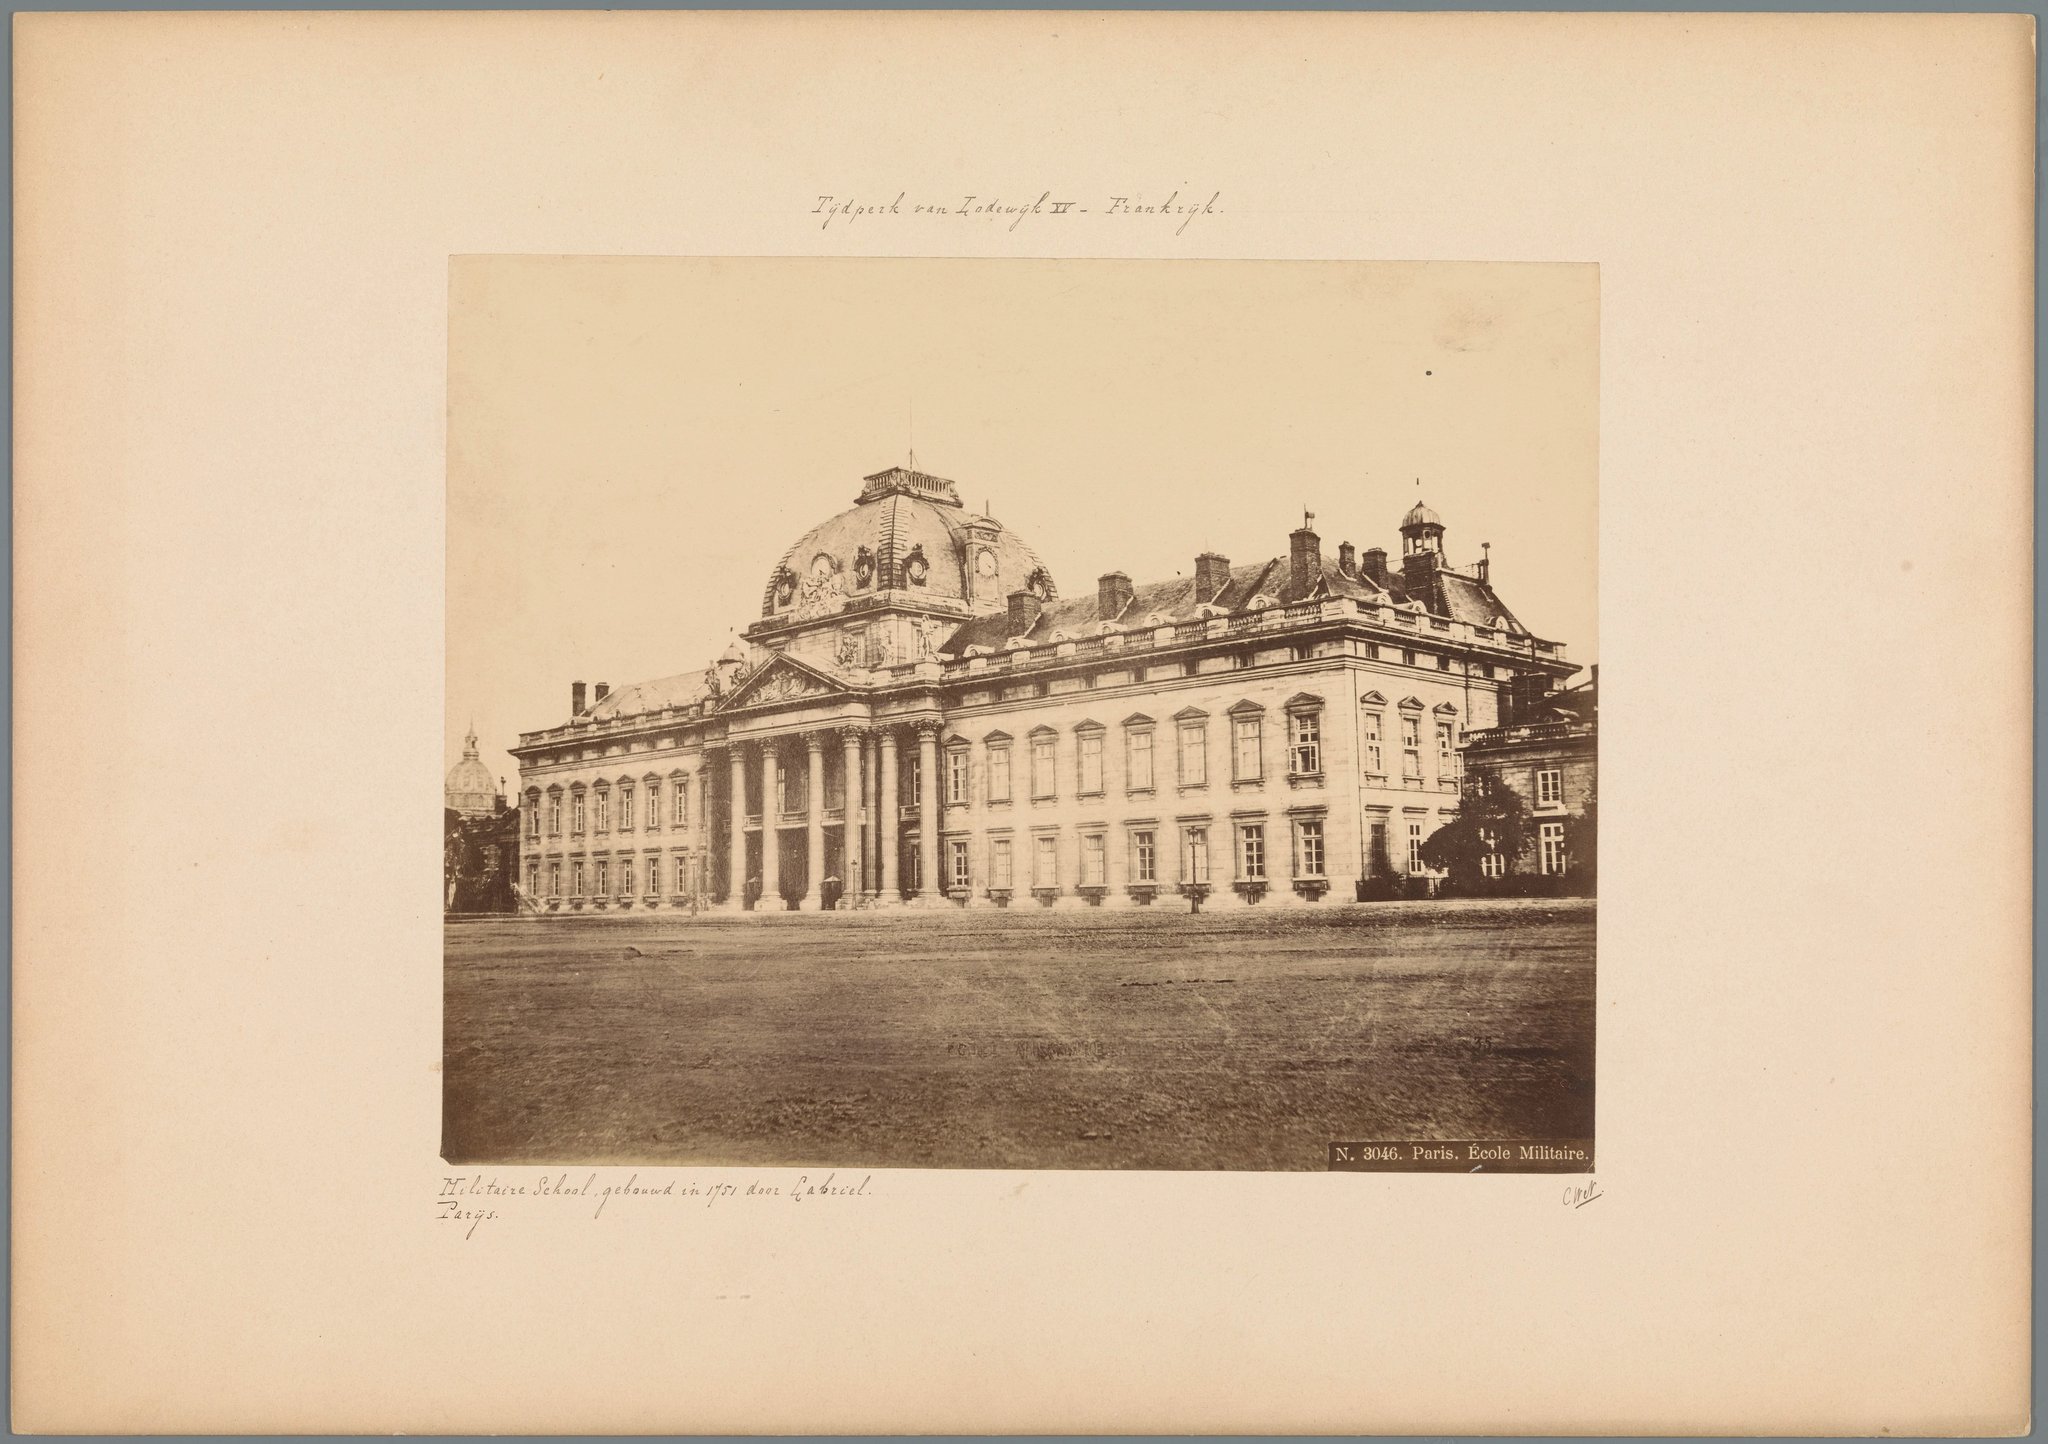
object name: photograph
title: Paris. École Militaire.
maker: Anonymous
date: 1875-1900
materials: cardboard, photographic support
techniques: albumen print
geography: paris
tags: military academy (+ naval force), paris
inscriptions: collector's mark: ‘INSTITUUT VOOR KUNST-NIJVERHEIDSONDERWIJS GABRIËL METSUSTRAAT No. 16 AMSTERDAM’, collector's mark: ‘KUNSTNIJVERHEIDSCHOOL QUELLINUS AMSTERDAM FRANS HALSSTRAAT 14.’, number: ‘N. 3046.’, number: ‘35’, inscription: ‘CWN.’, inscription: ‘Tijdperk van Lodewijk XV - Frankrijk.’